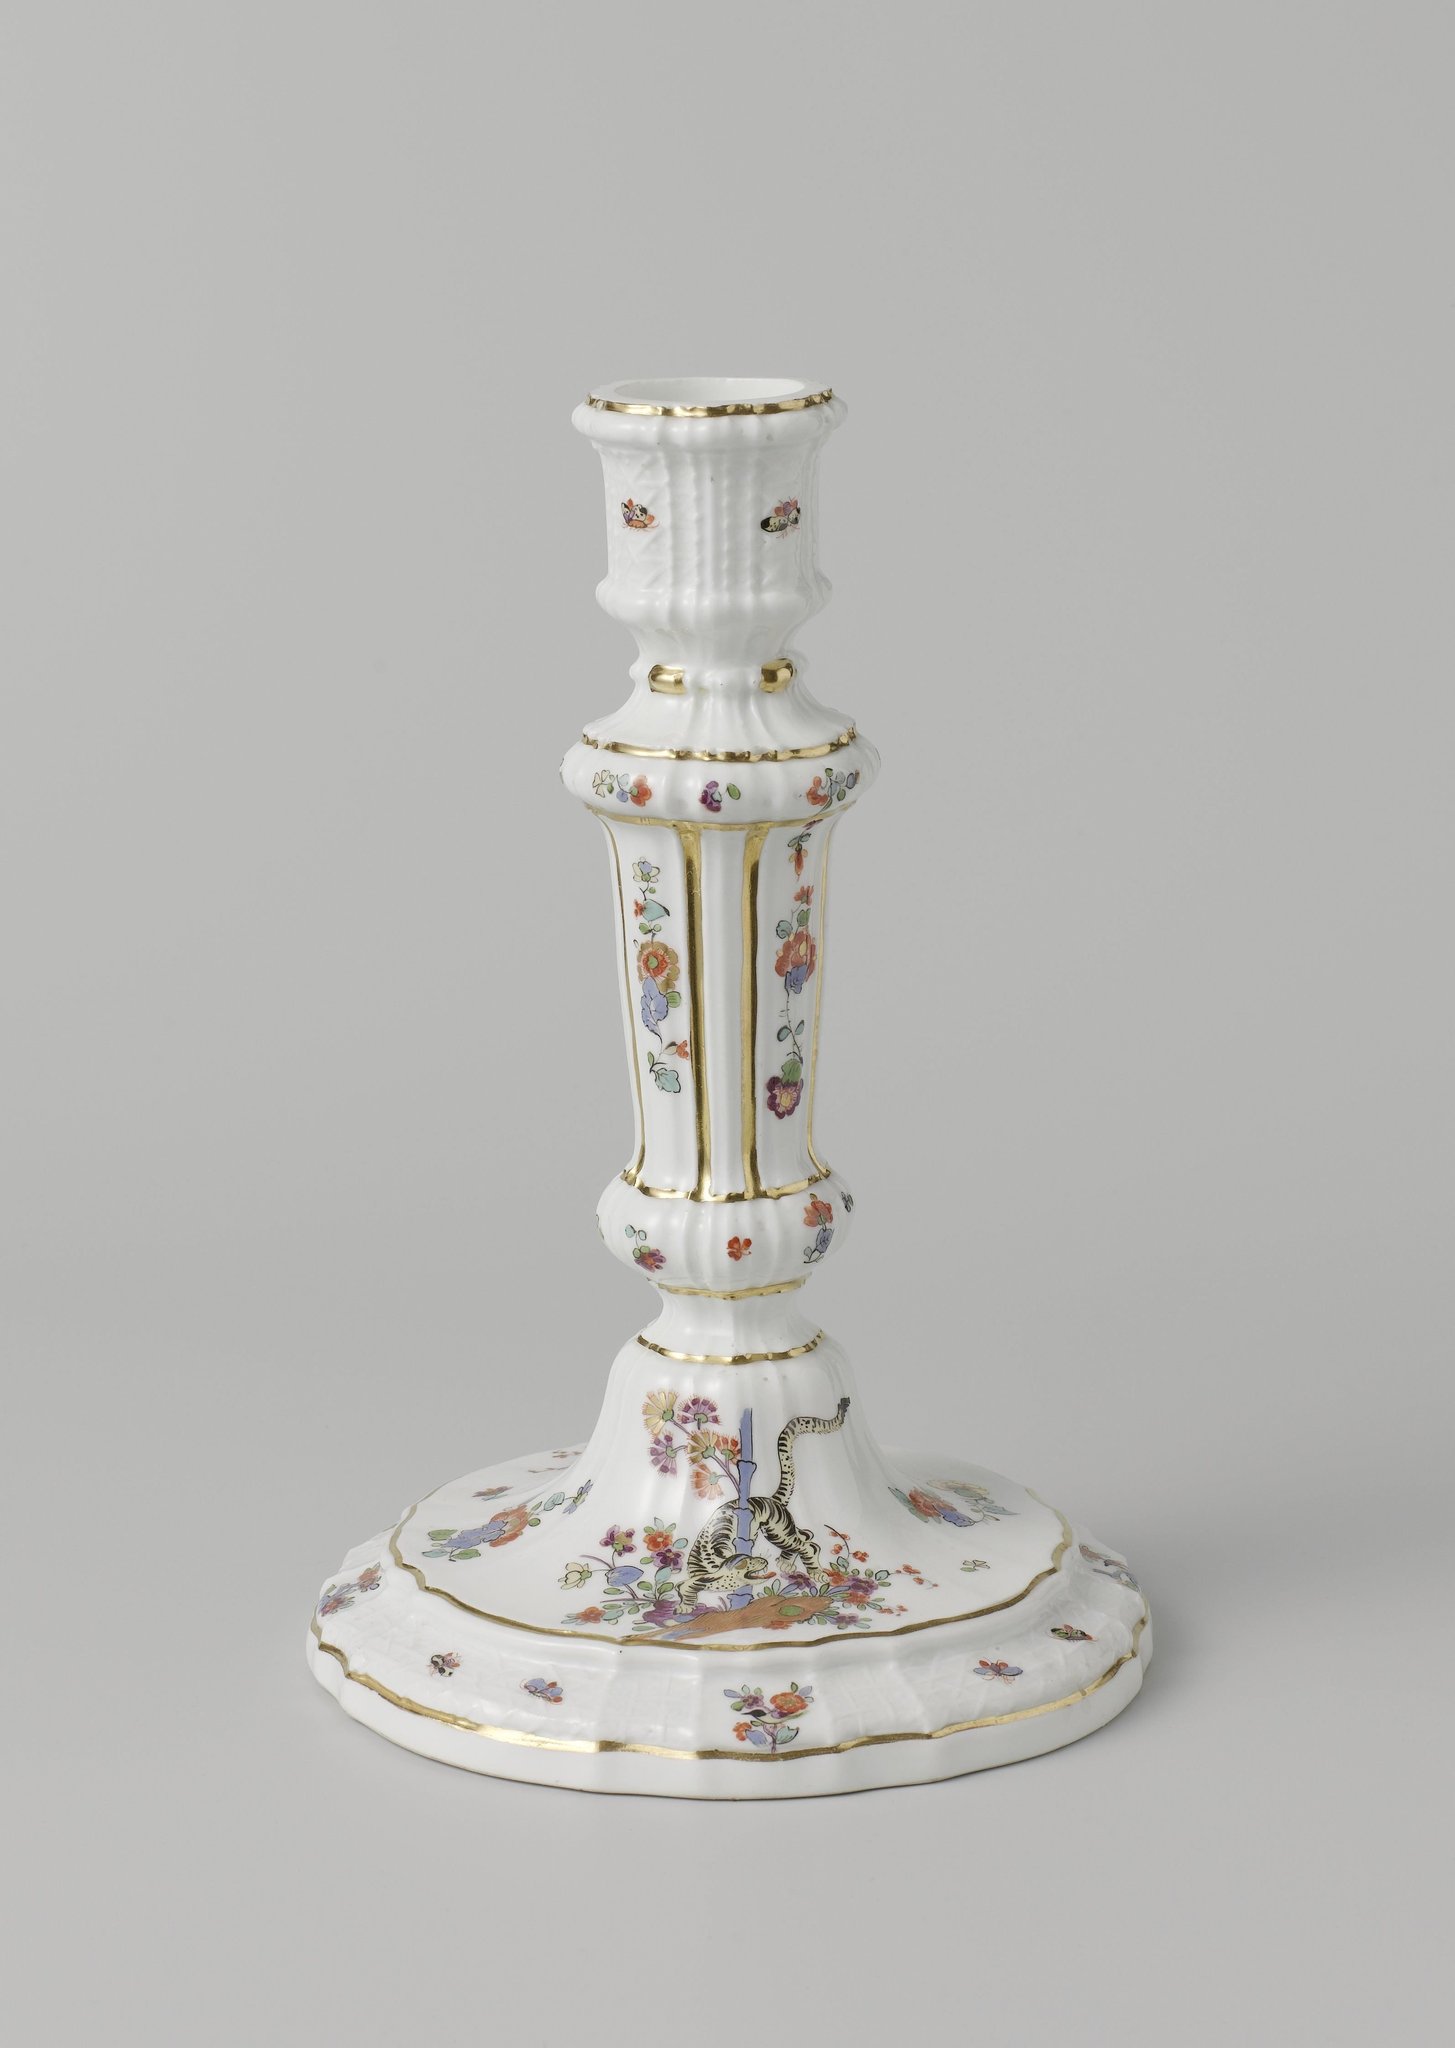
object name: candlestick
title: Kandelaar, veelkleurig beschilderd met een Kakiemon-decor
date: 1740-1745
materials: porcelain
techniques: painted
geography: meissen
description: Kandelaar van beschilderd porselein. De kandelaar heeft een ronde, geschulpte voet met een geprofileerde stam met twee nodi. Op de kaarsenhouder en de voetrand is het 'Altbrandenstein'-patroon geschilderd. Op de voet is een tijger om een bamboestengel in bloemen geschilderd. De kandelaar is gemerkt.